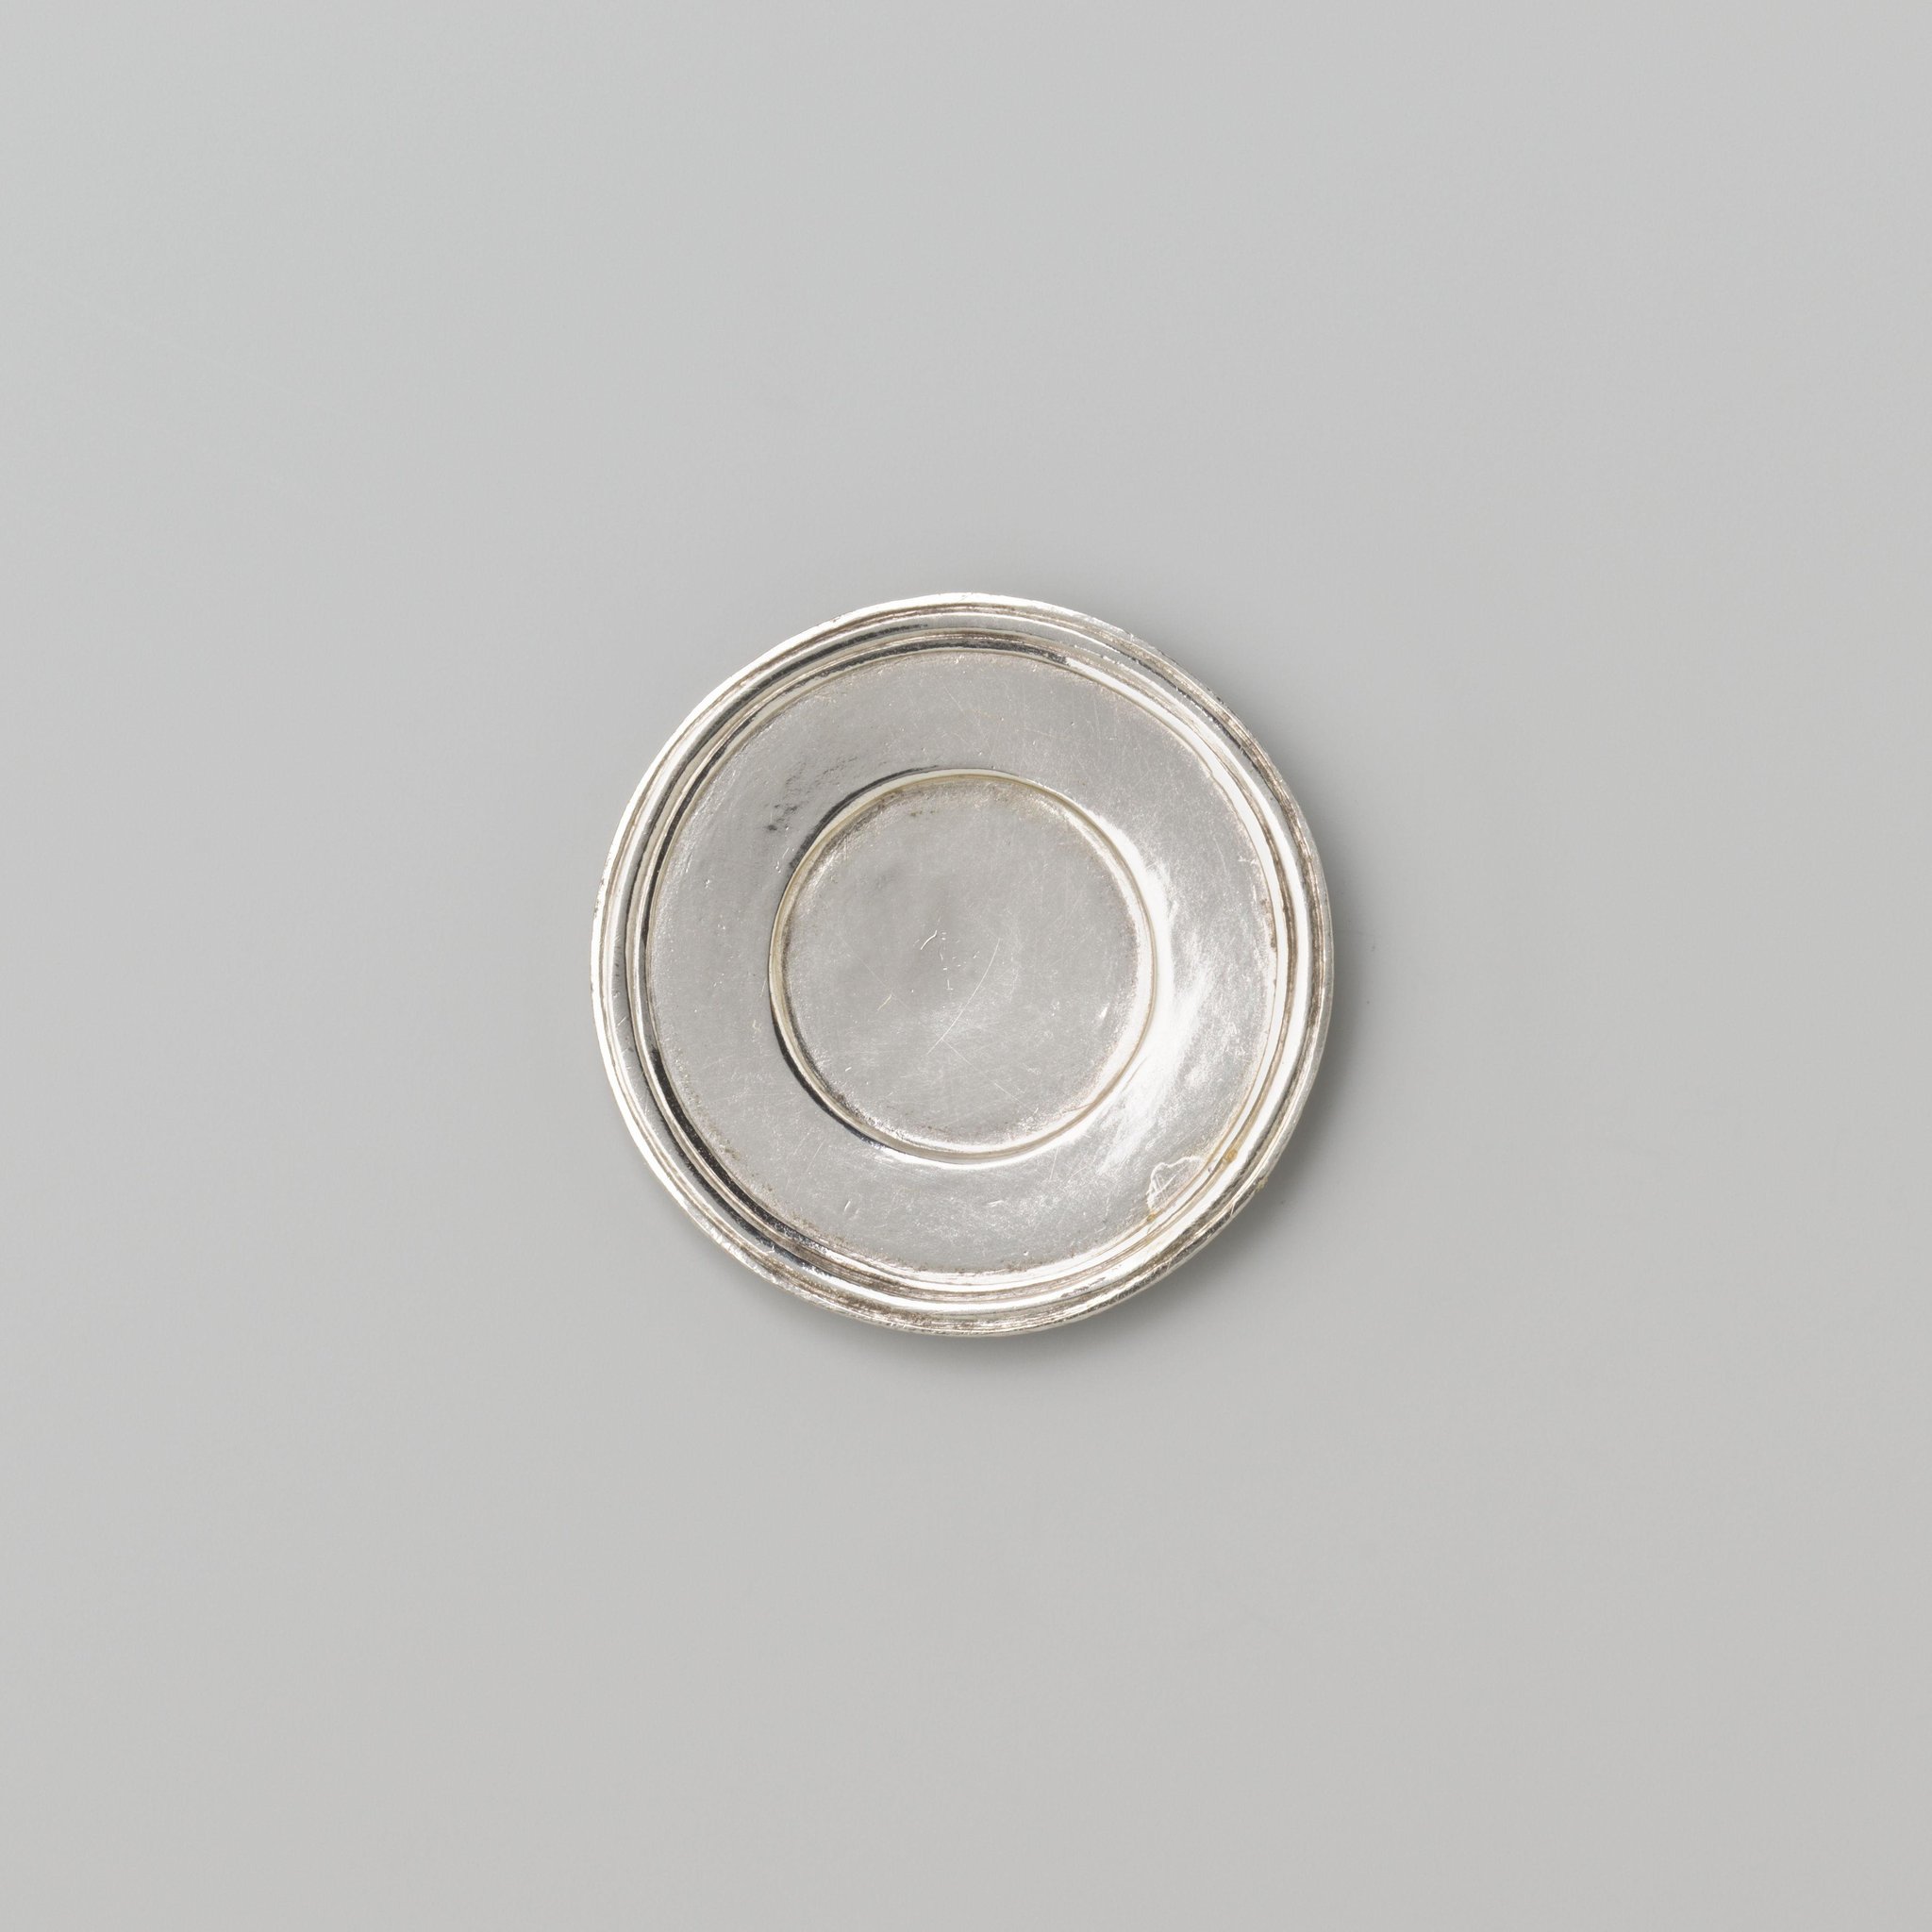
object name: platter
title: Zilverkleurige schoteltje met brede platte geprofileerde rand.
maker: Anonymous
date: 1700-1710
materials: copper alloy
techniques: silvering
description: Zilverkleurige schotel met brede, platte geprofileerde rand.